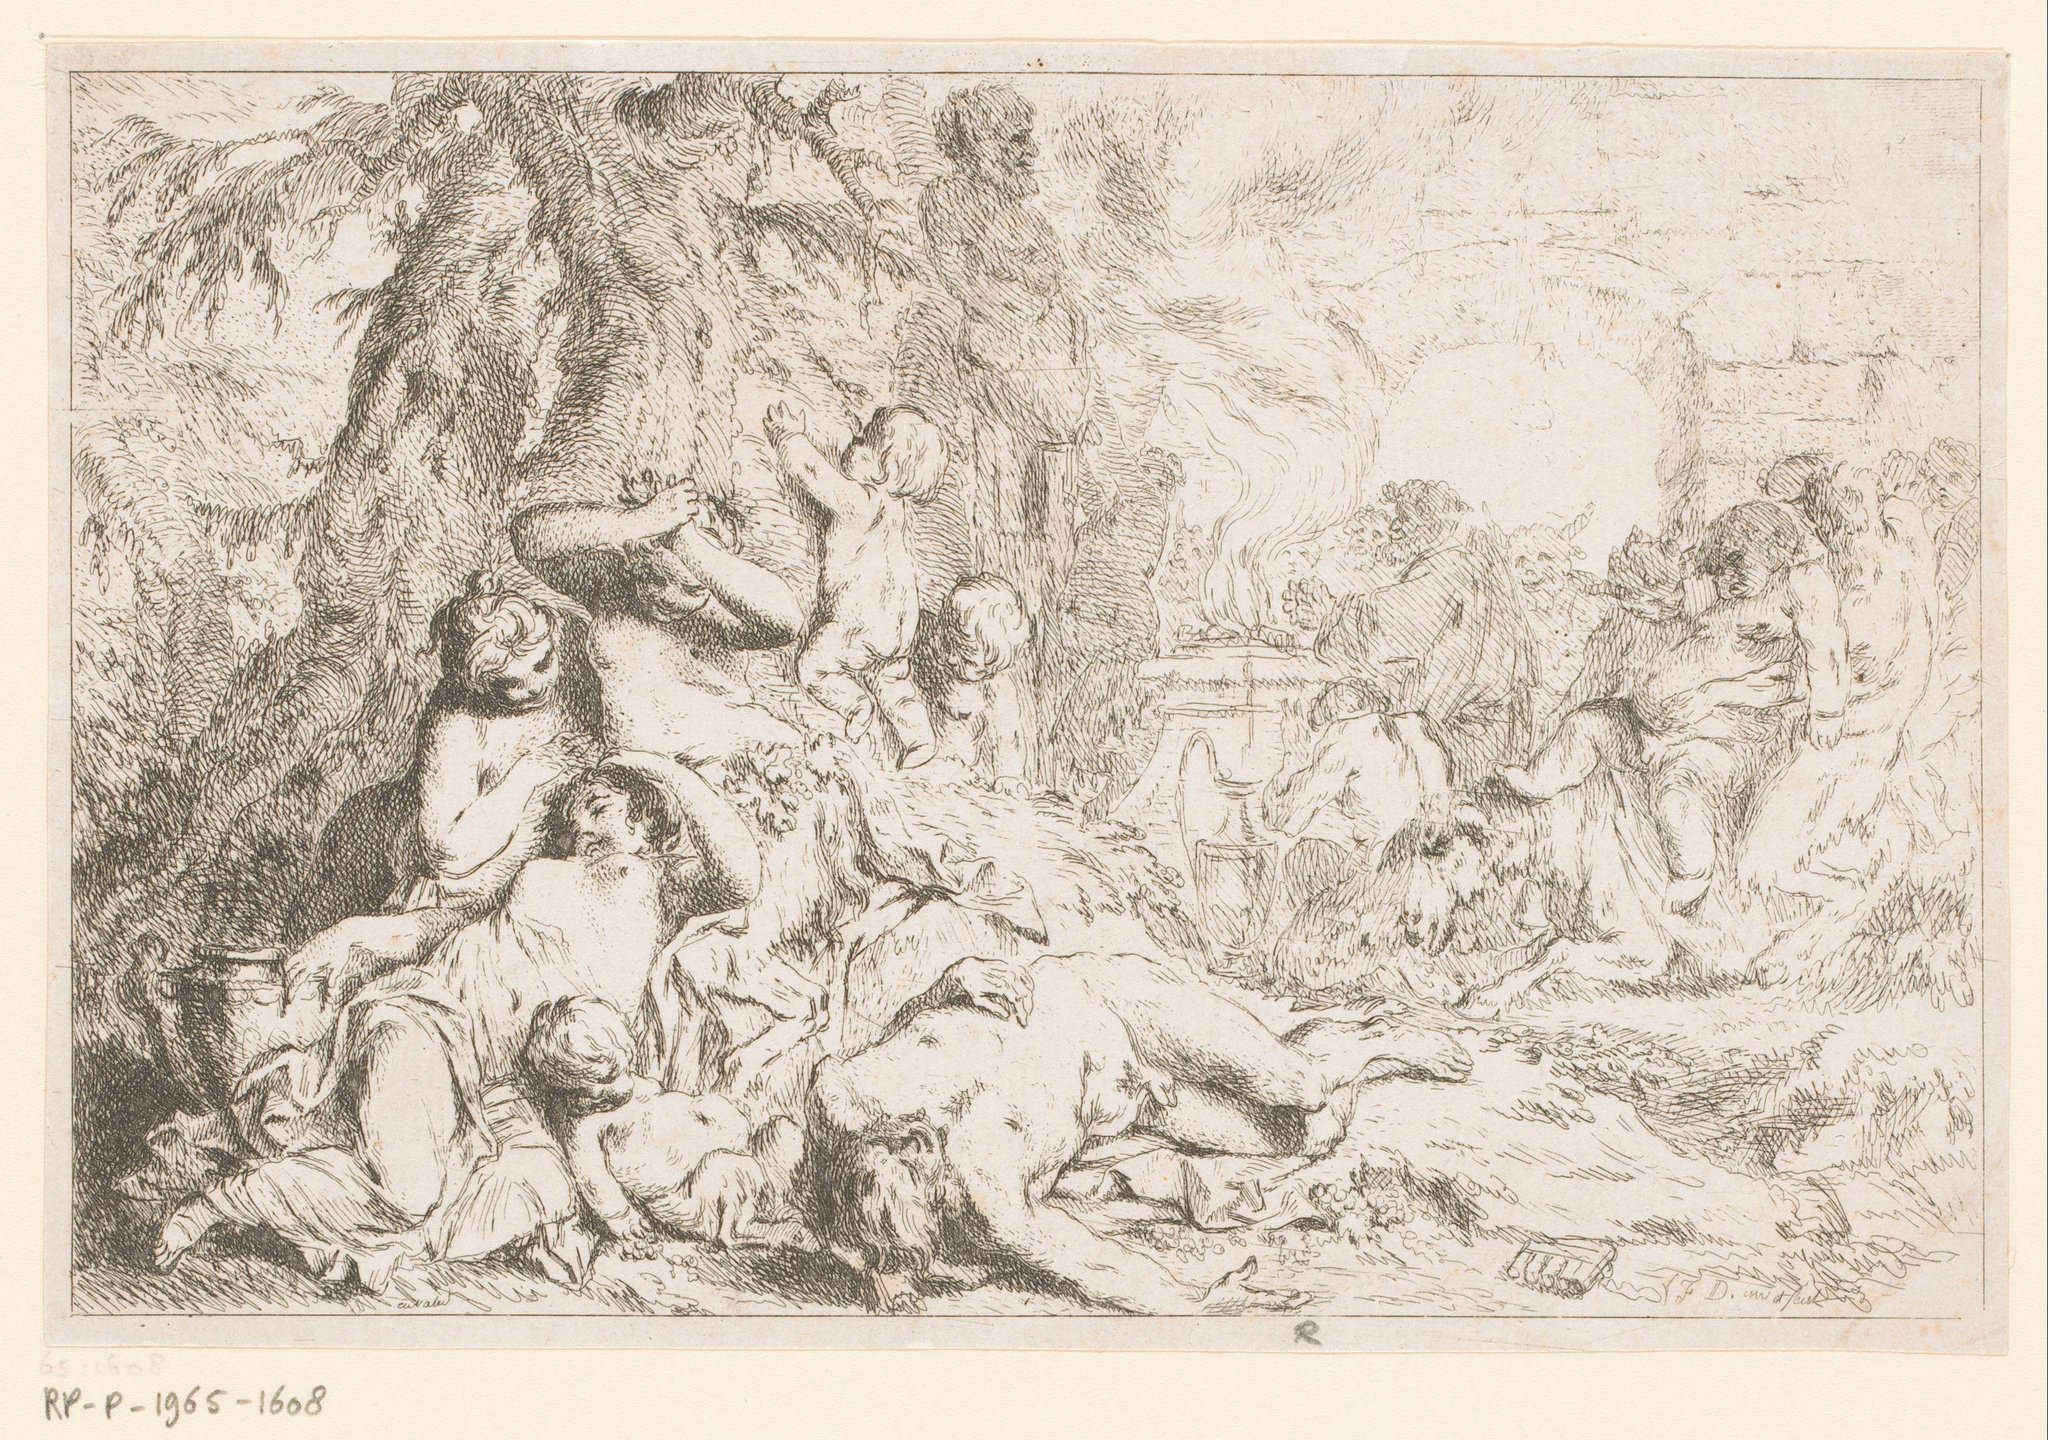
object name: print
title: Bacchanaal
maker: monogrammist fd (graveur)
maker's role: print maker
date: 1700-1799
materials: paper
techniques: etching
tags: thiasos, i.e. bacchus' revel-rout, bacchanal without bacchus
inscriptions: watermark, collector's mark: Lugt 2228